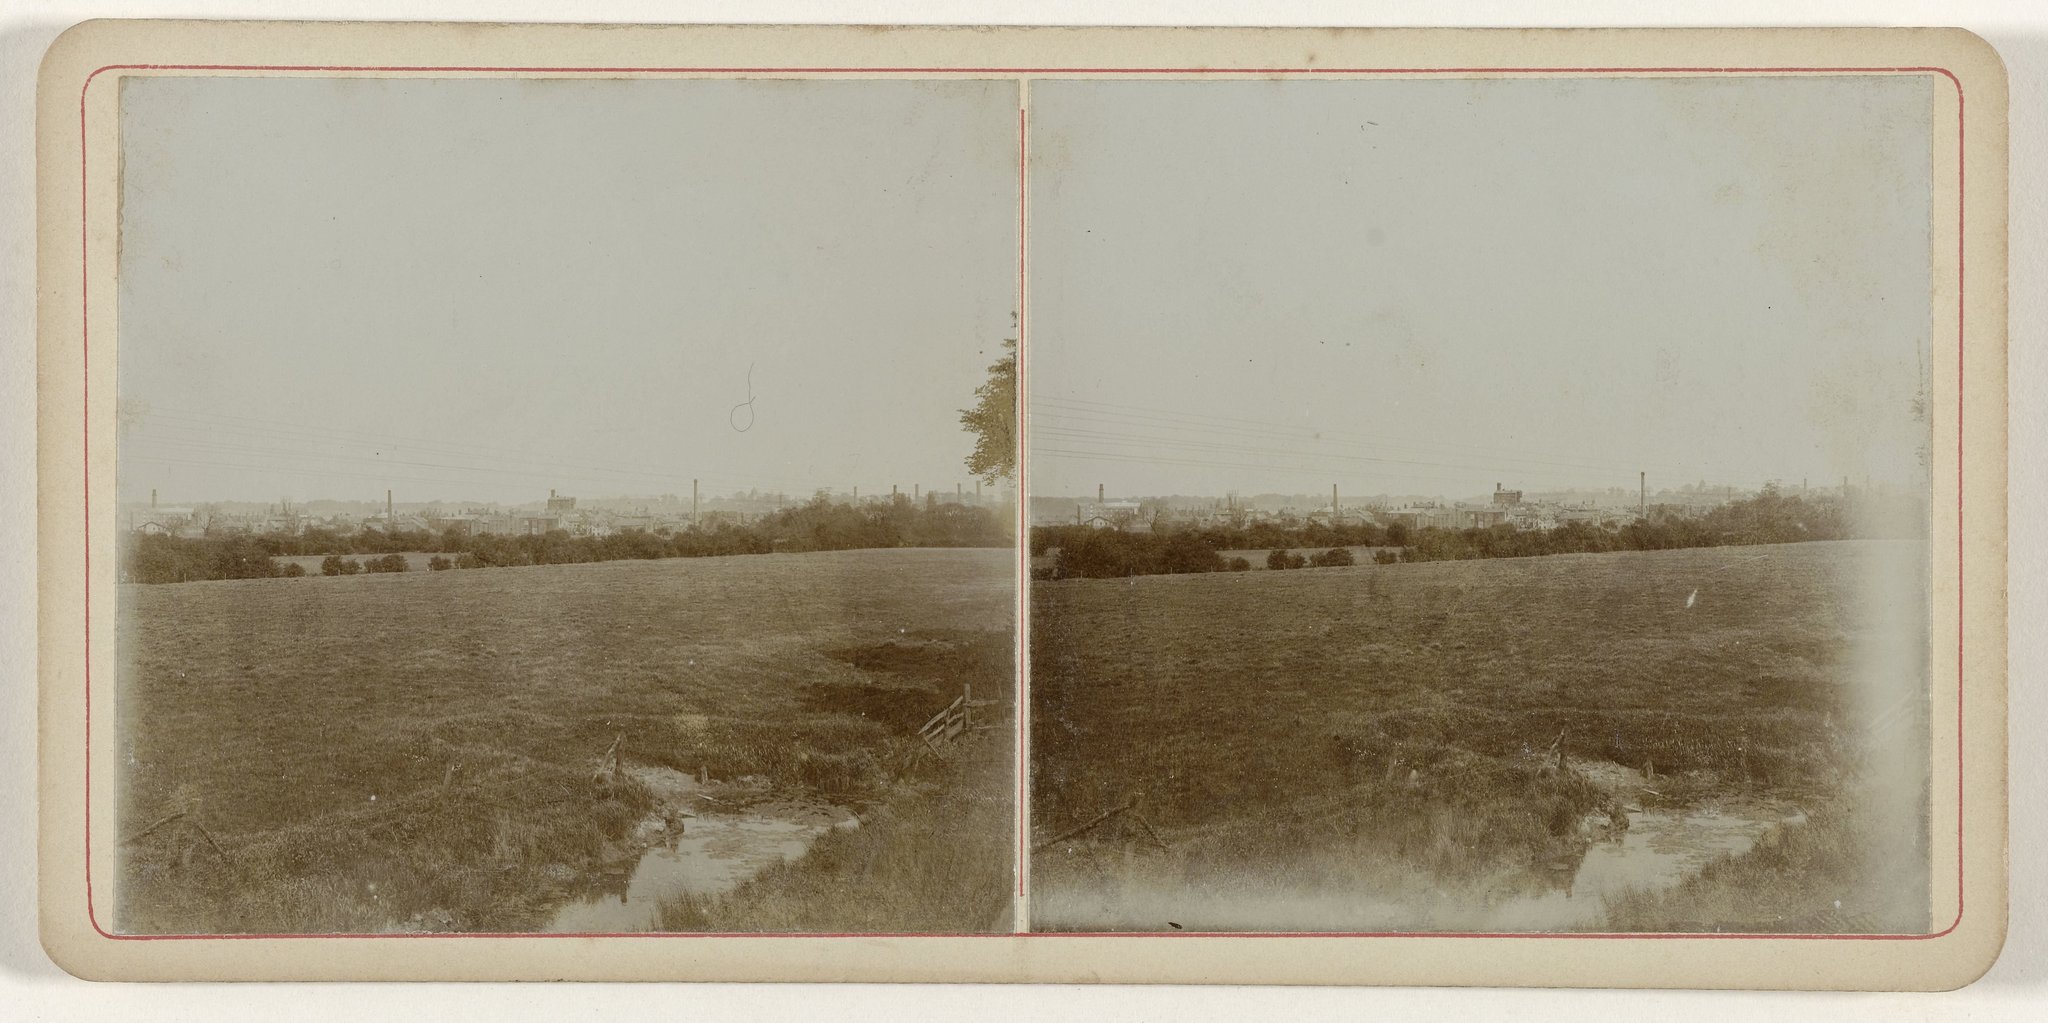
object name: stereograph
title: Gainsborough, begin 1904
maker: geldolph adriaan kessler (dolph)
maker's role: fotograaf, industrieel, voetballer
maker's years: 1884-1945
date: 1904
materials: paper, photographic support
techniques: collodion silver print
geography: gelderland